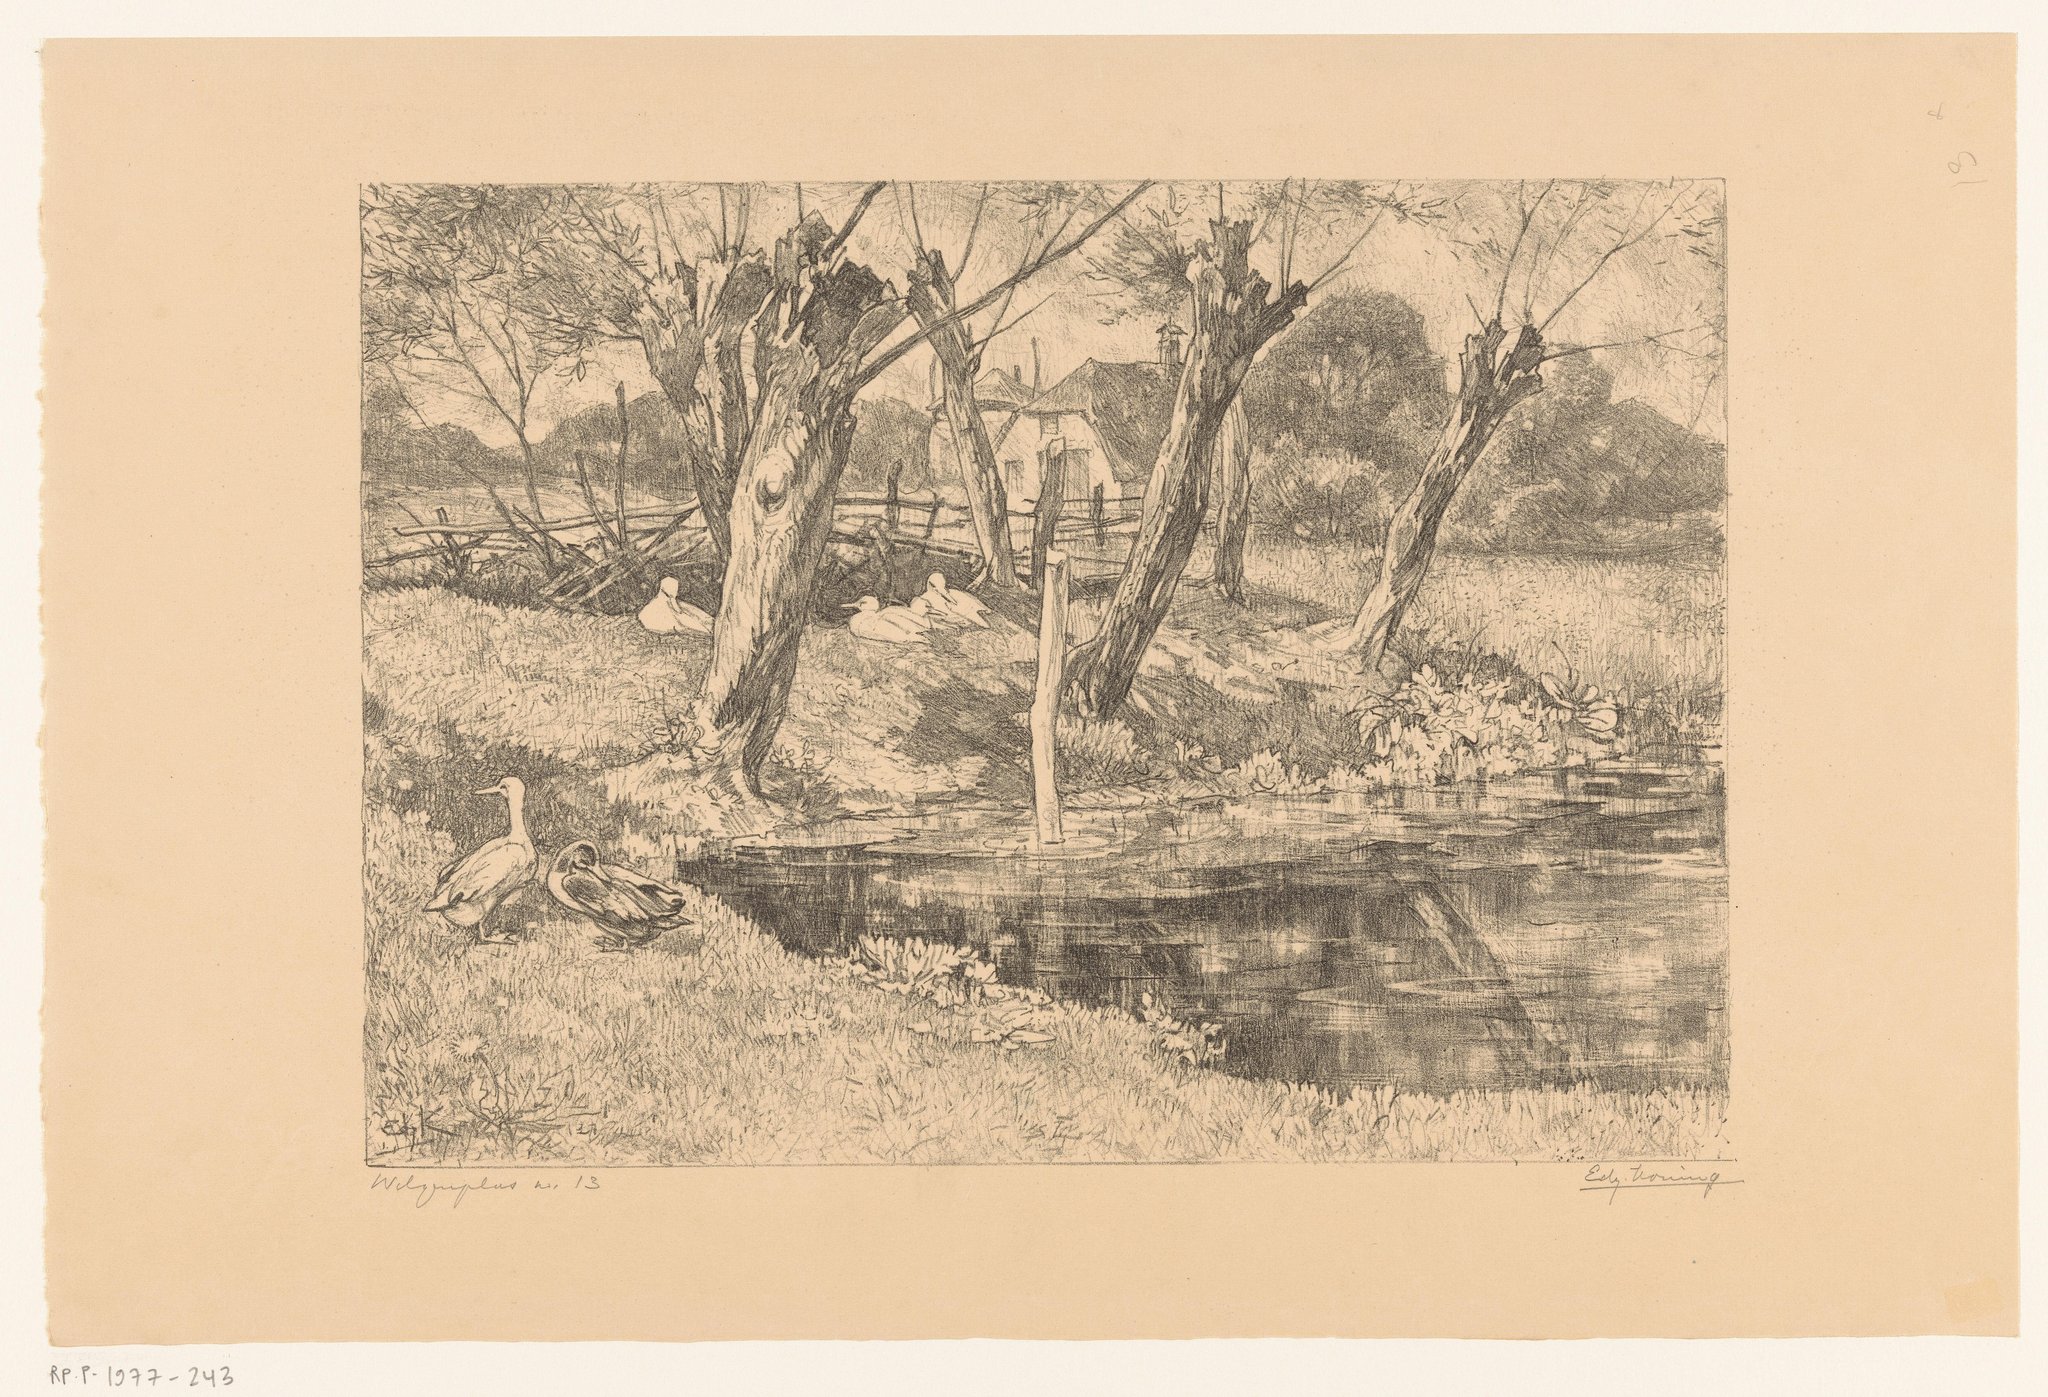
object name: print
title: Wilgenplas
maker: edzard koning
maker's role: draughtsman, print maker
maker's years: 1869-1954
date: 1879-1954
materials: paper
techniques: lithograph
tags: trees: willow, farm or solitary house in landscape, water-birds: duck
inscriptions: number: ‘13’, collector's mark: Lugt 2228, collector's mark: Lugt 2760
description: Knotwilgen aan het water. Onder de wilgen liggen en staan eenden. Op de achtergrond een boerderij met hooischuur.